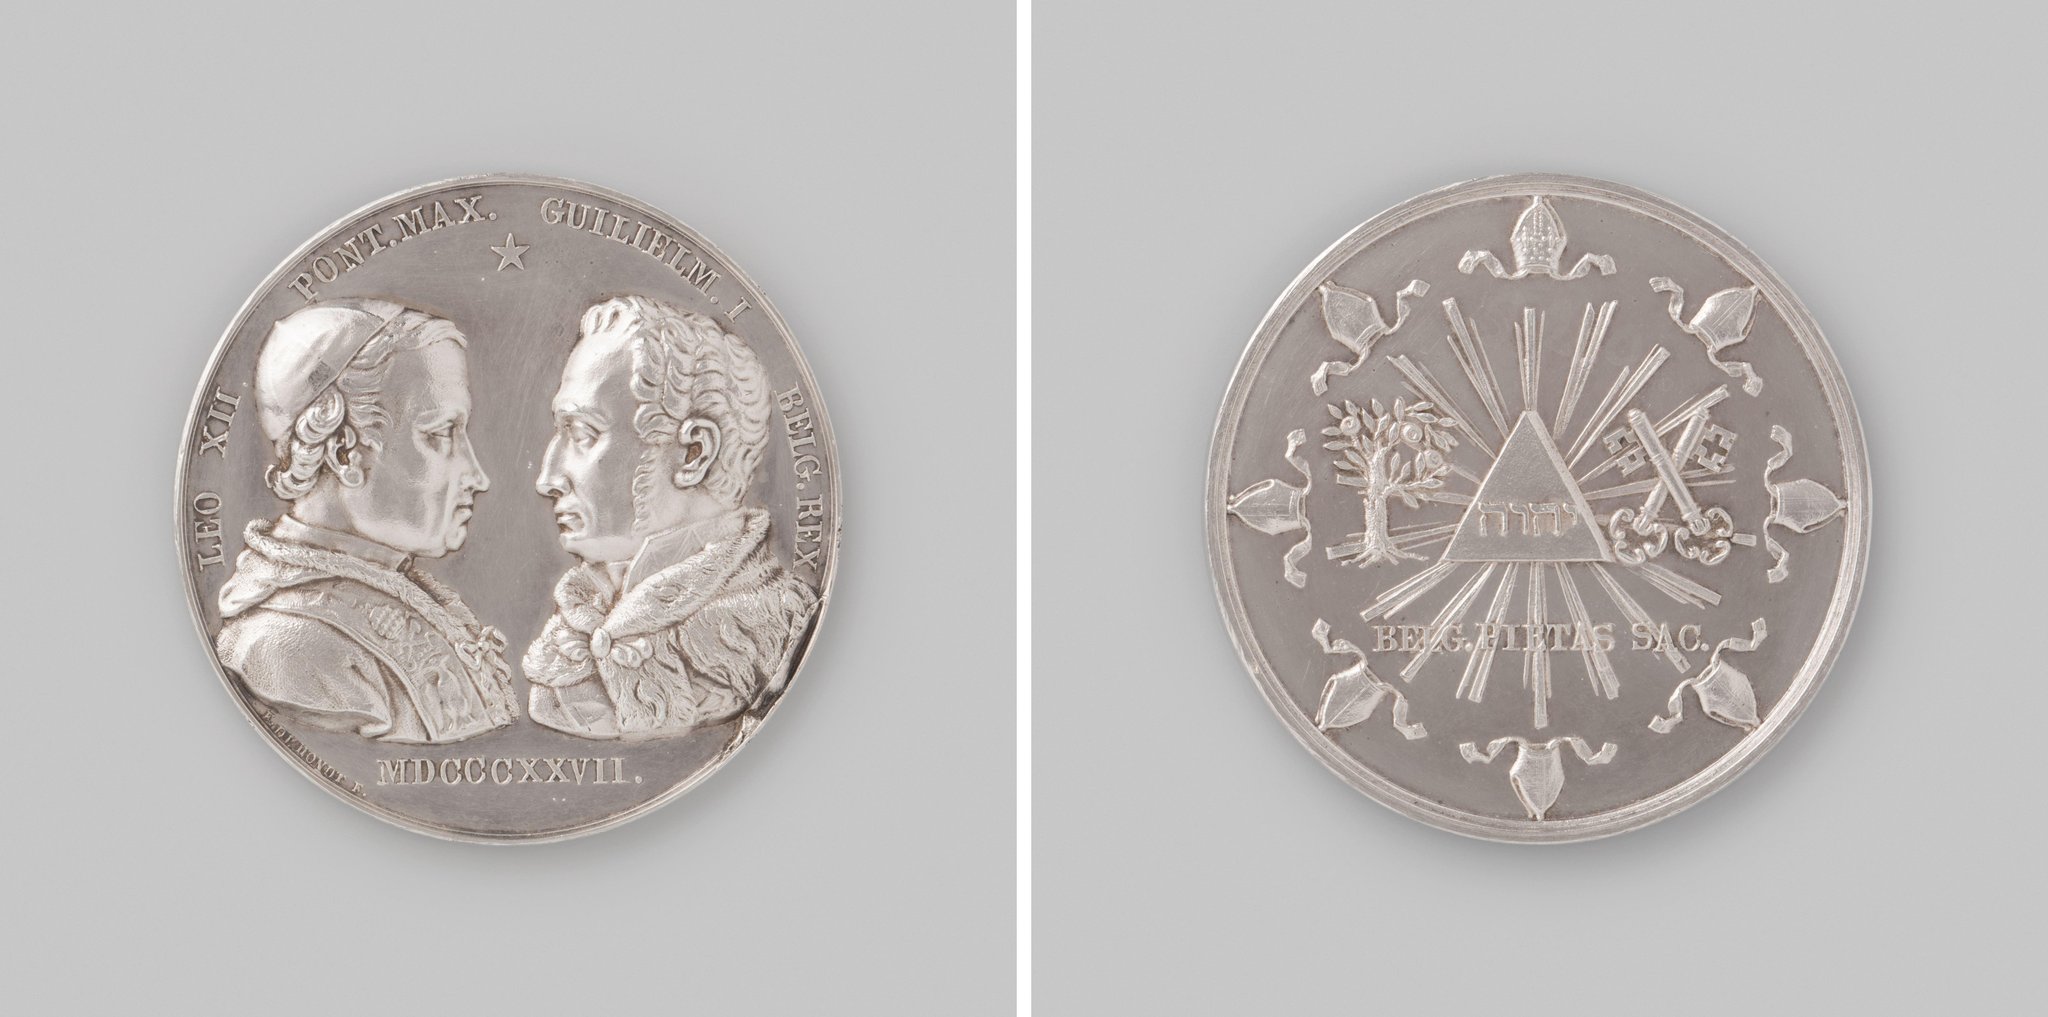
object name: history medal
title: Concordaat tussen paus Leo XII en Willem I Frederik, koning der Nederlanden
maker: franciscus johannes de hondt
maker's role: print maker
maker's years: 1786-1862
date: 1827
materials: silver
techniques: striking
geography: bruges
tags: william i of the netherlands, rome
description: Zilveren penning. Voorzijde: naar elkaar gewende borststukken van twee mannen binnen omschrift; afsnede: jaartal. Keerzijde: stralende driehoek met opschrift in Hebreeuwse letters tussen oranjeboom en twee gekruiste sleutels, boven opschrift binnen kring van acht mijters.